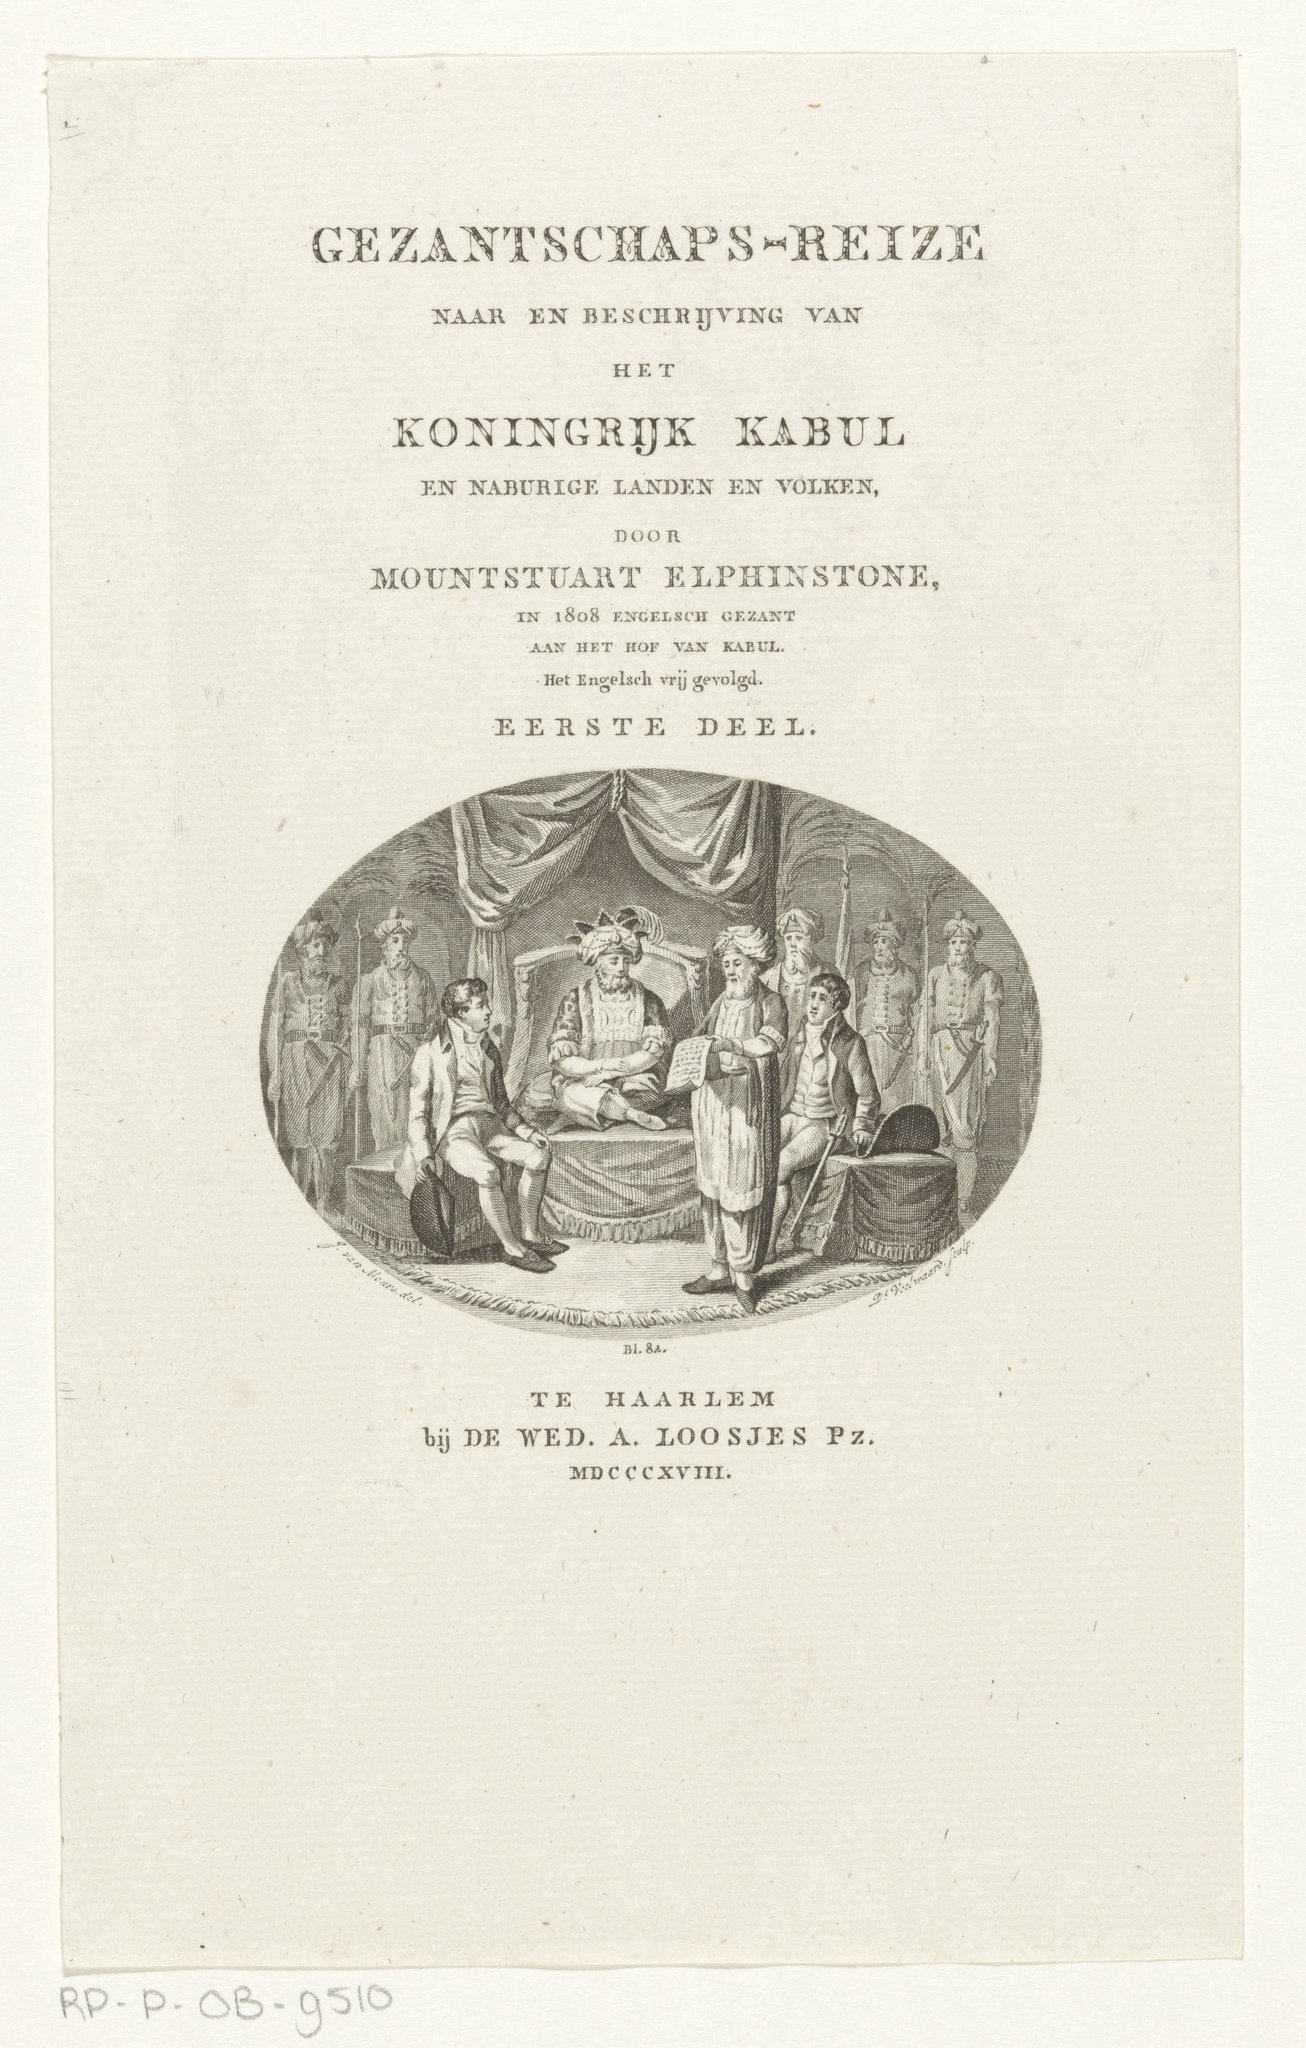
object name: print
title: Titelpagina voor: Mountstuart Elphinstone, Gezantschaps-reize naar en beschrijving van het koningrijk Kabul, 1818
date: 1818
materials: paper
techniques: engraving, etching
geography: haarlem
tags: visiting; receiving guests; elegant company, king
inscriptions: collector's mark: Lugt 2228, collector's mark: Lugt 2760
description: Haarlem: Elphinstone, Mountstuart. Gezantschaps-reize naar en beschrijving van het koningrijk Kabul en naburige landen en volken, eerste deel. Loosjes Pz., weduwe Adriaan, 1818.